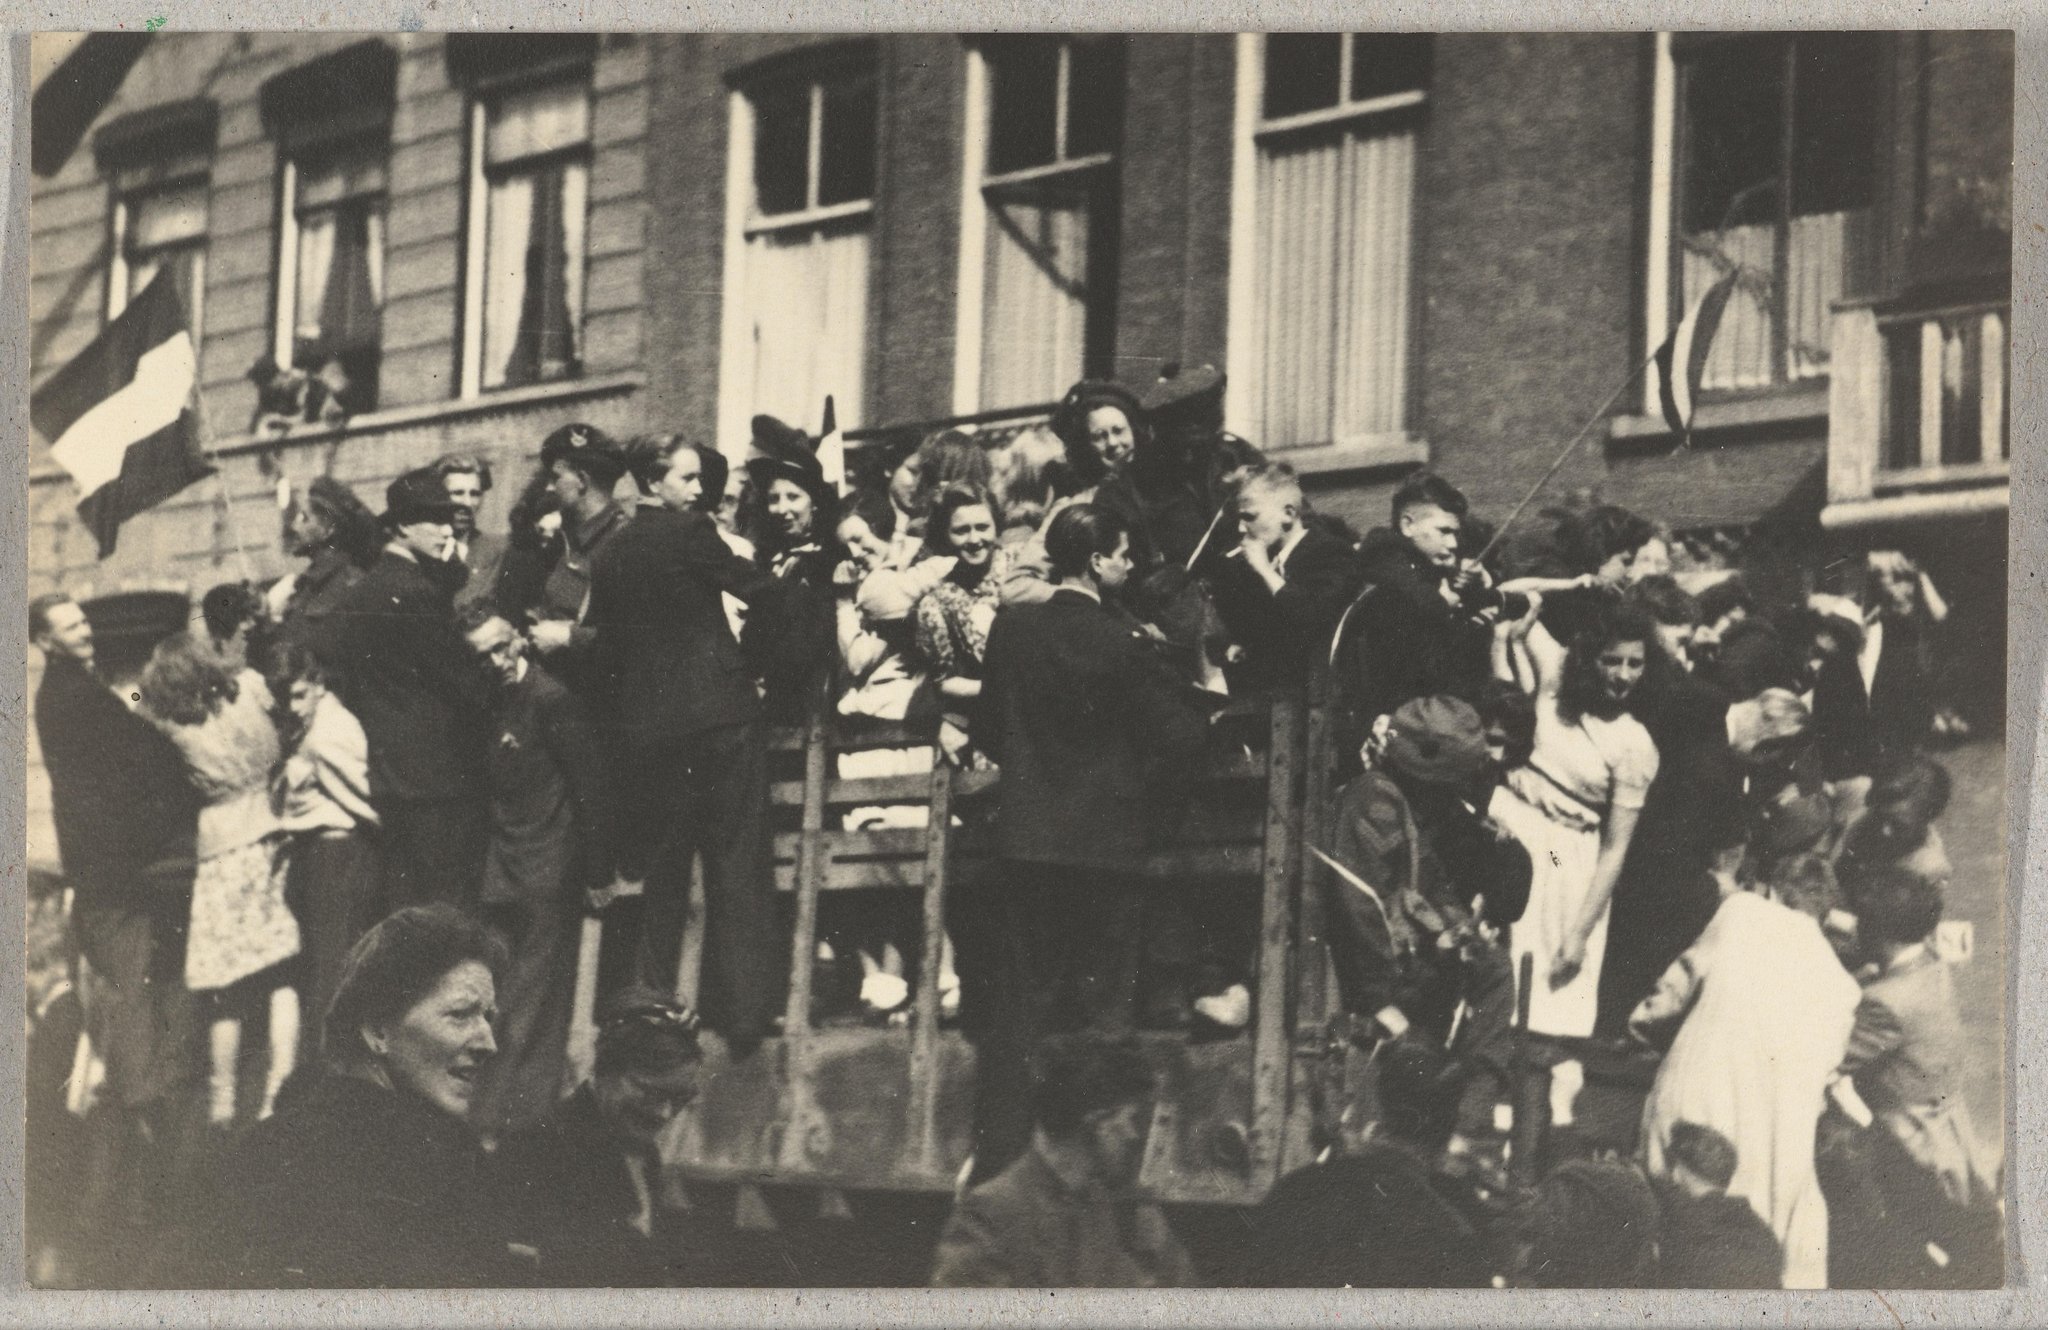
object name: photograph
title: Bevrijding van Amsterdam in mei 1945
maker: Anonymous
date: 1945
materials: paper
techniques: gelatin silver print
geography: amsterdam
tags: festivities, amsterdam